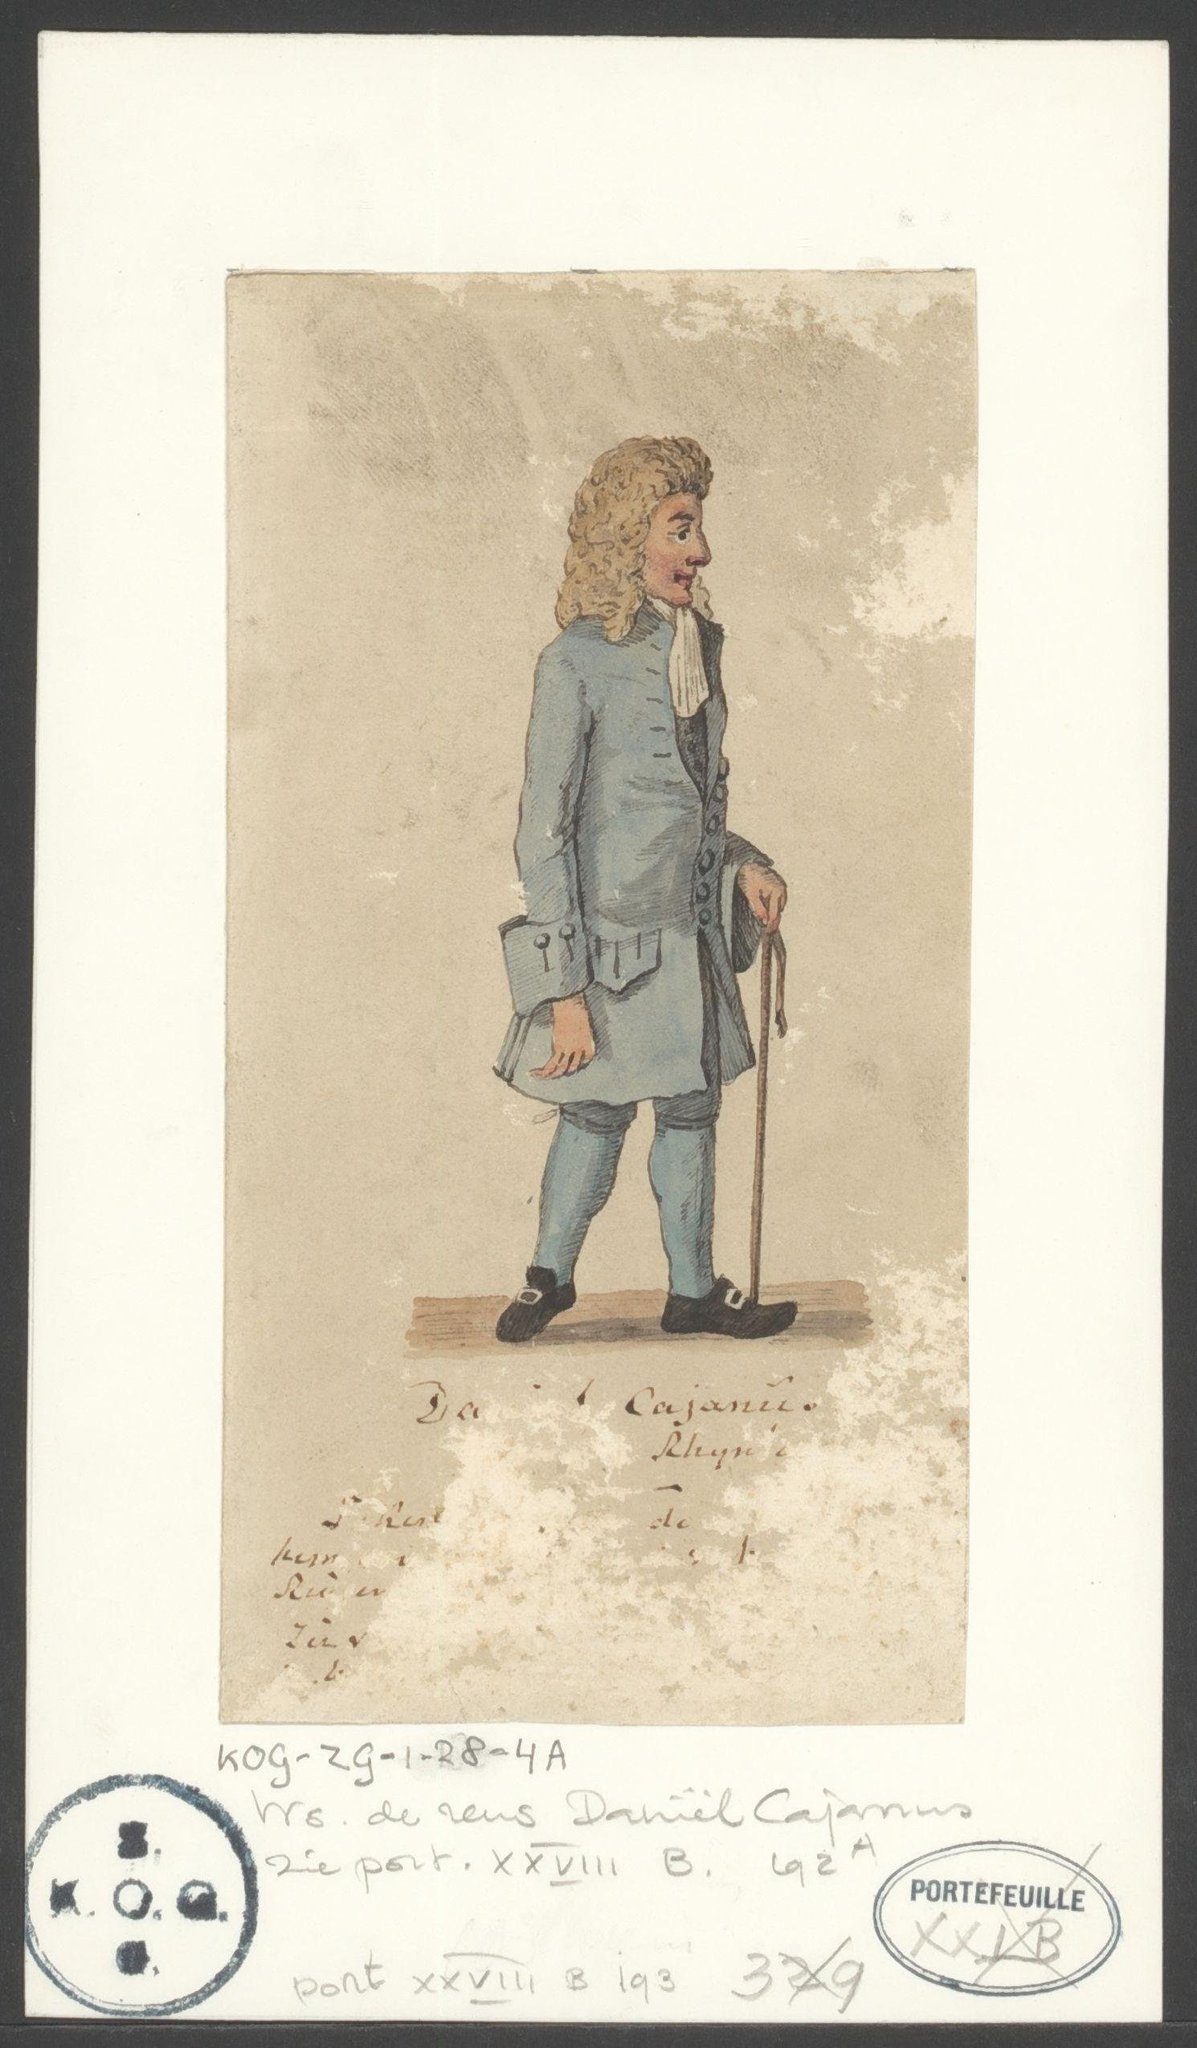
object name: drawing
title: Portret van Daniel Cajanus, ten voeten uit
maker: Anonymous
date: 1714-1749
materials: ink, paper, watercolor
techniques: brush, pen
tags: giants, colossi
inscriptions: collector's mark: Lugt 1641, stamp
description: Portret van de reus Daniel Cajanus. Onderwerpsrubrieken binnen de Atlas Zeden en Gewoonten: Zeden en Gewoonten in Engeren Zin. Volksleven. Volksfeesten. Kermistypen, wondermenschen en dergelijken.